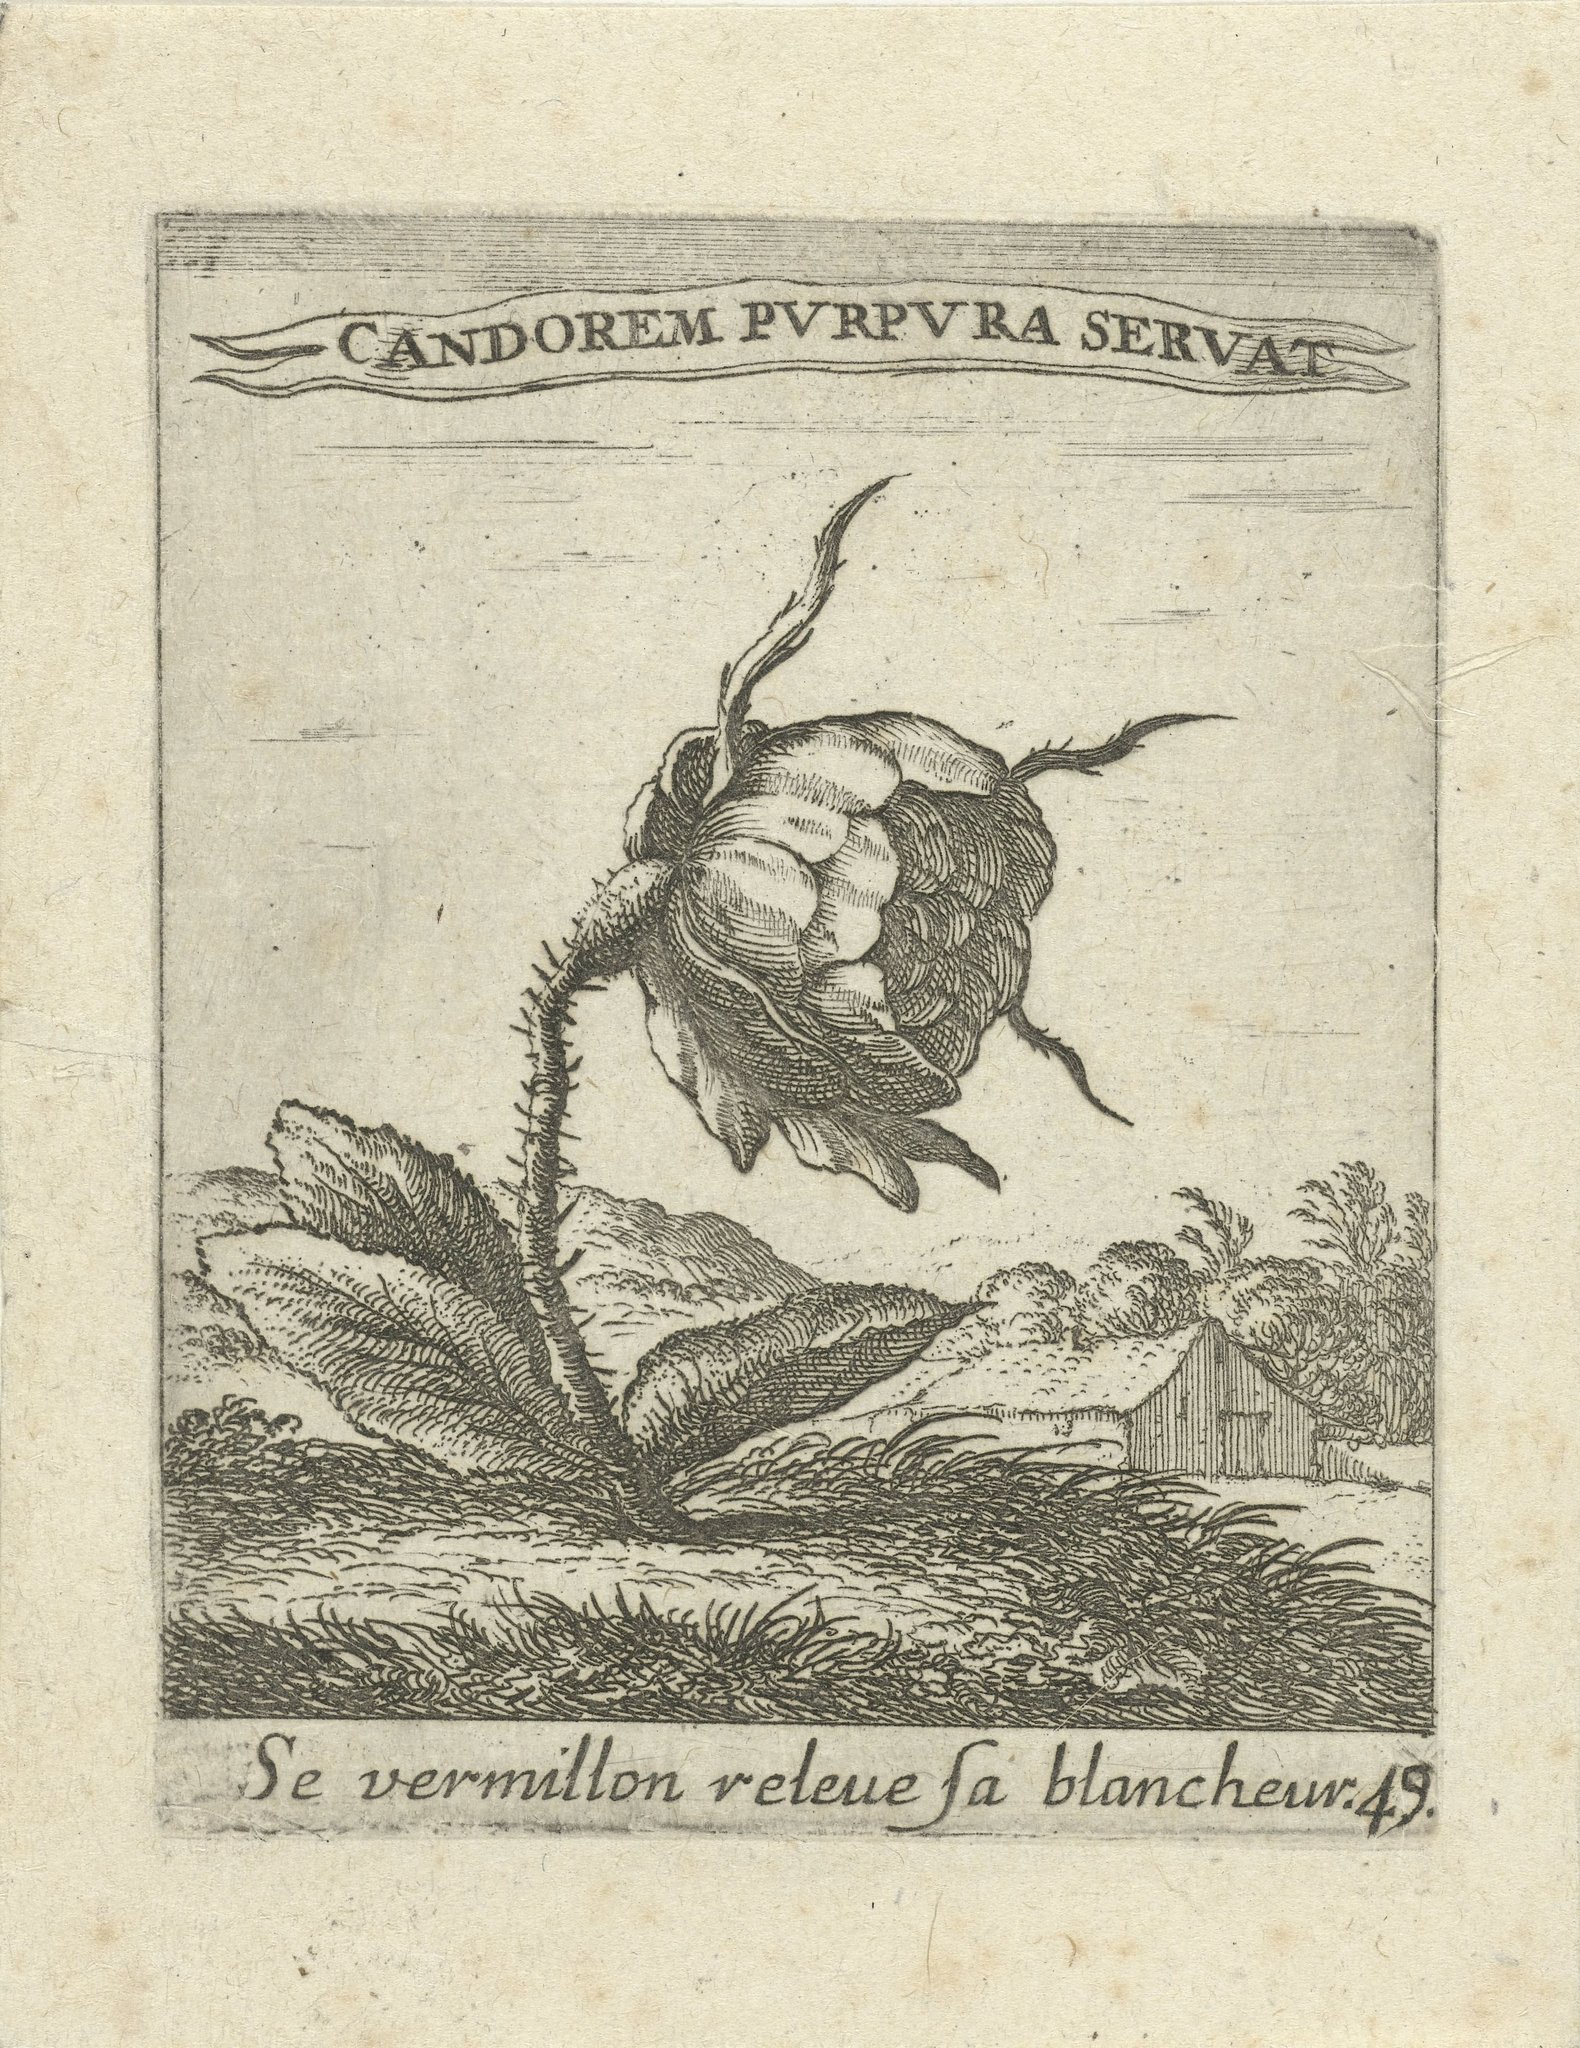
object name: print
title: Moraliserende liefdesemblemen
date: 1672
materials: paper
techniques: etching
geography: paris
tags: qualities of love: first series (+ emblematical representation of concept)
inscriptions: collector's mark: Lugt 2166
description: Een bloeiende roos. Op een banderol een devies in Latijn en een onderschrift in Frans, beide over de liefde.